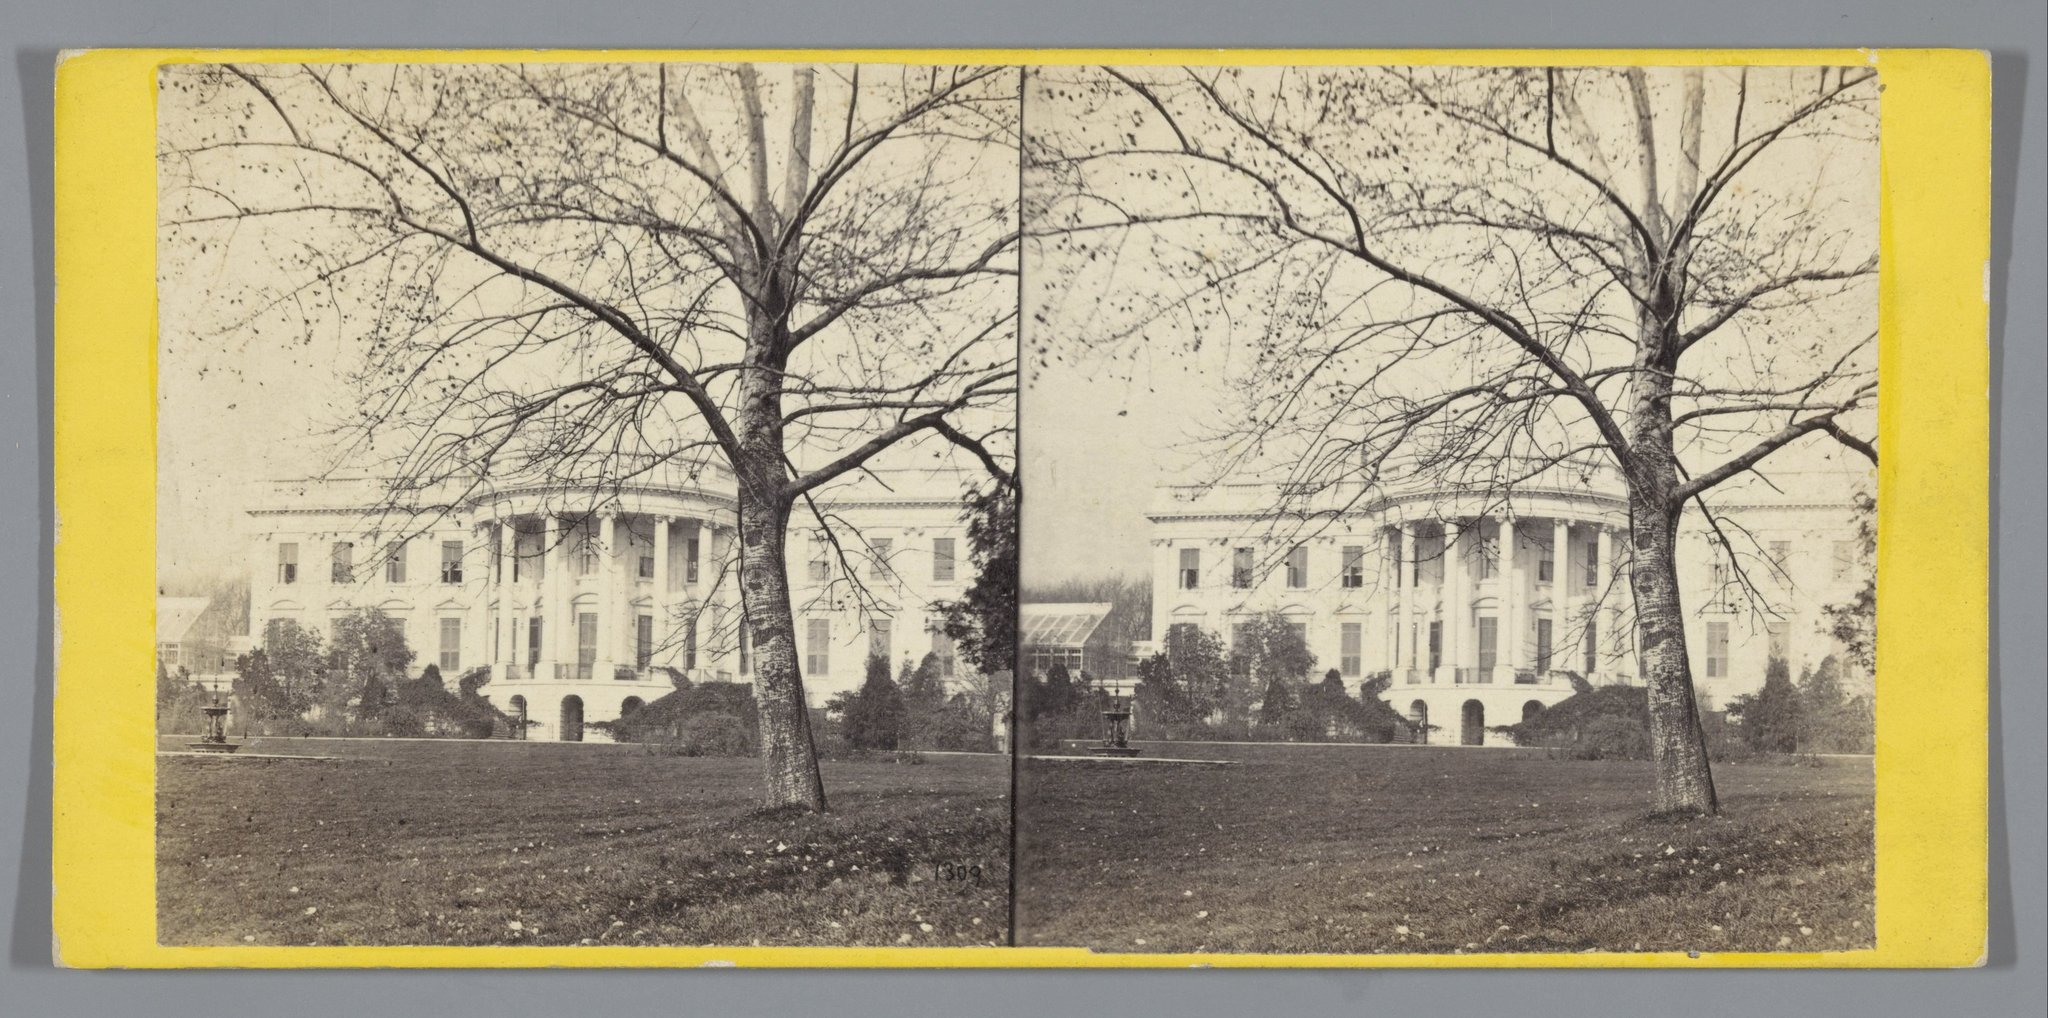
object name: stereograph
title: South Front of the White House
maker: Anonymous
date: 1864-1866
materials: cardboard, paper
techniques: albumen print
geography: washington d.c.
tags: villa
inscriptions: number: ‘1309’, address: ‘American and Foreign Stereoscopic Emporium, 501 Broadway, New-York.’